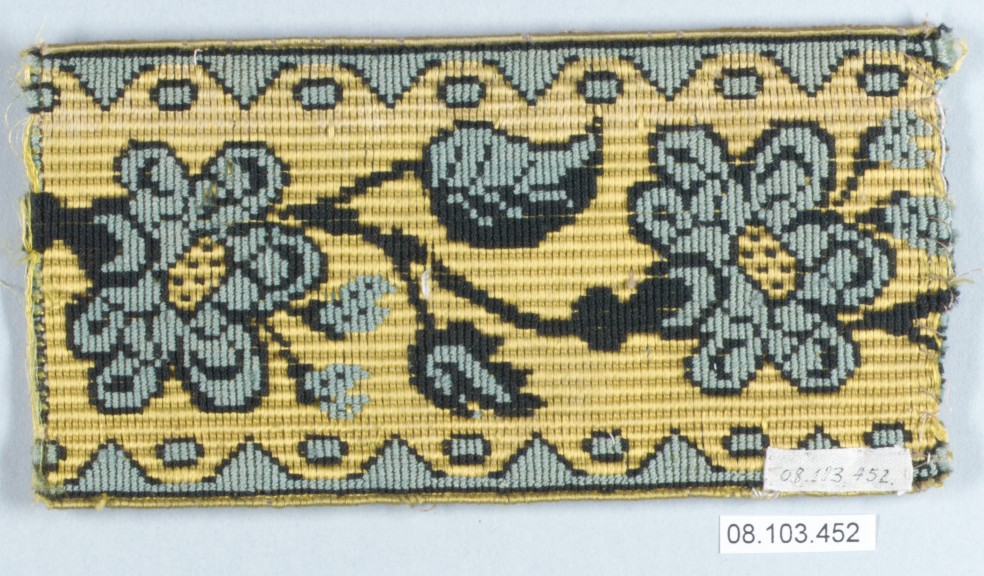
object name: galloon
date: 1801-1900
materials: silk, wool